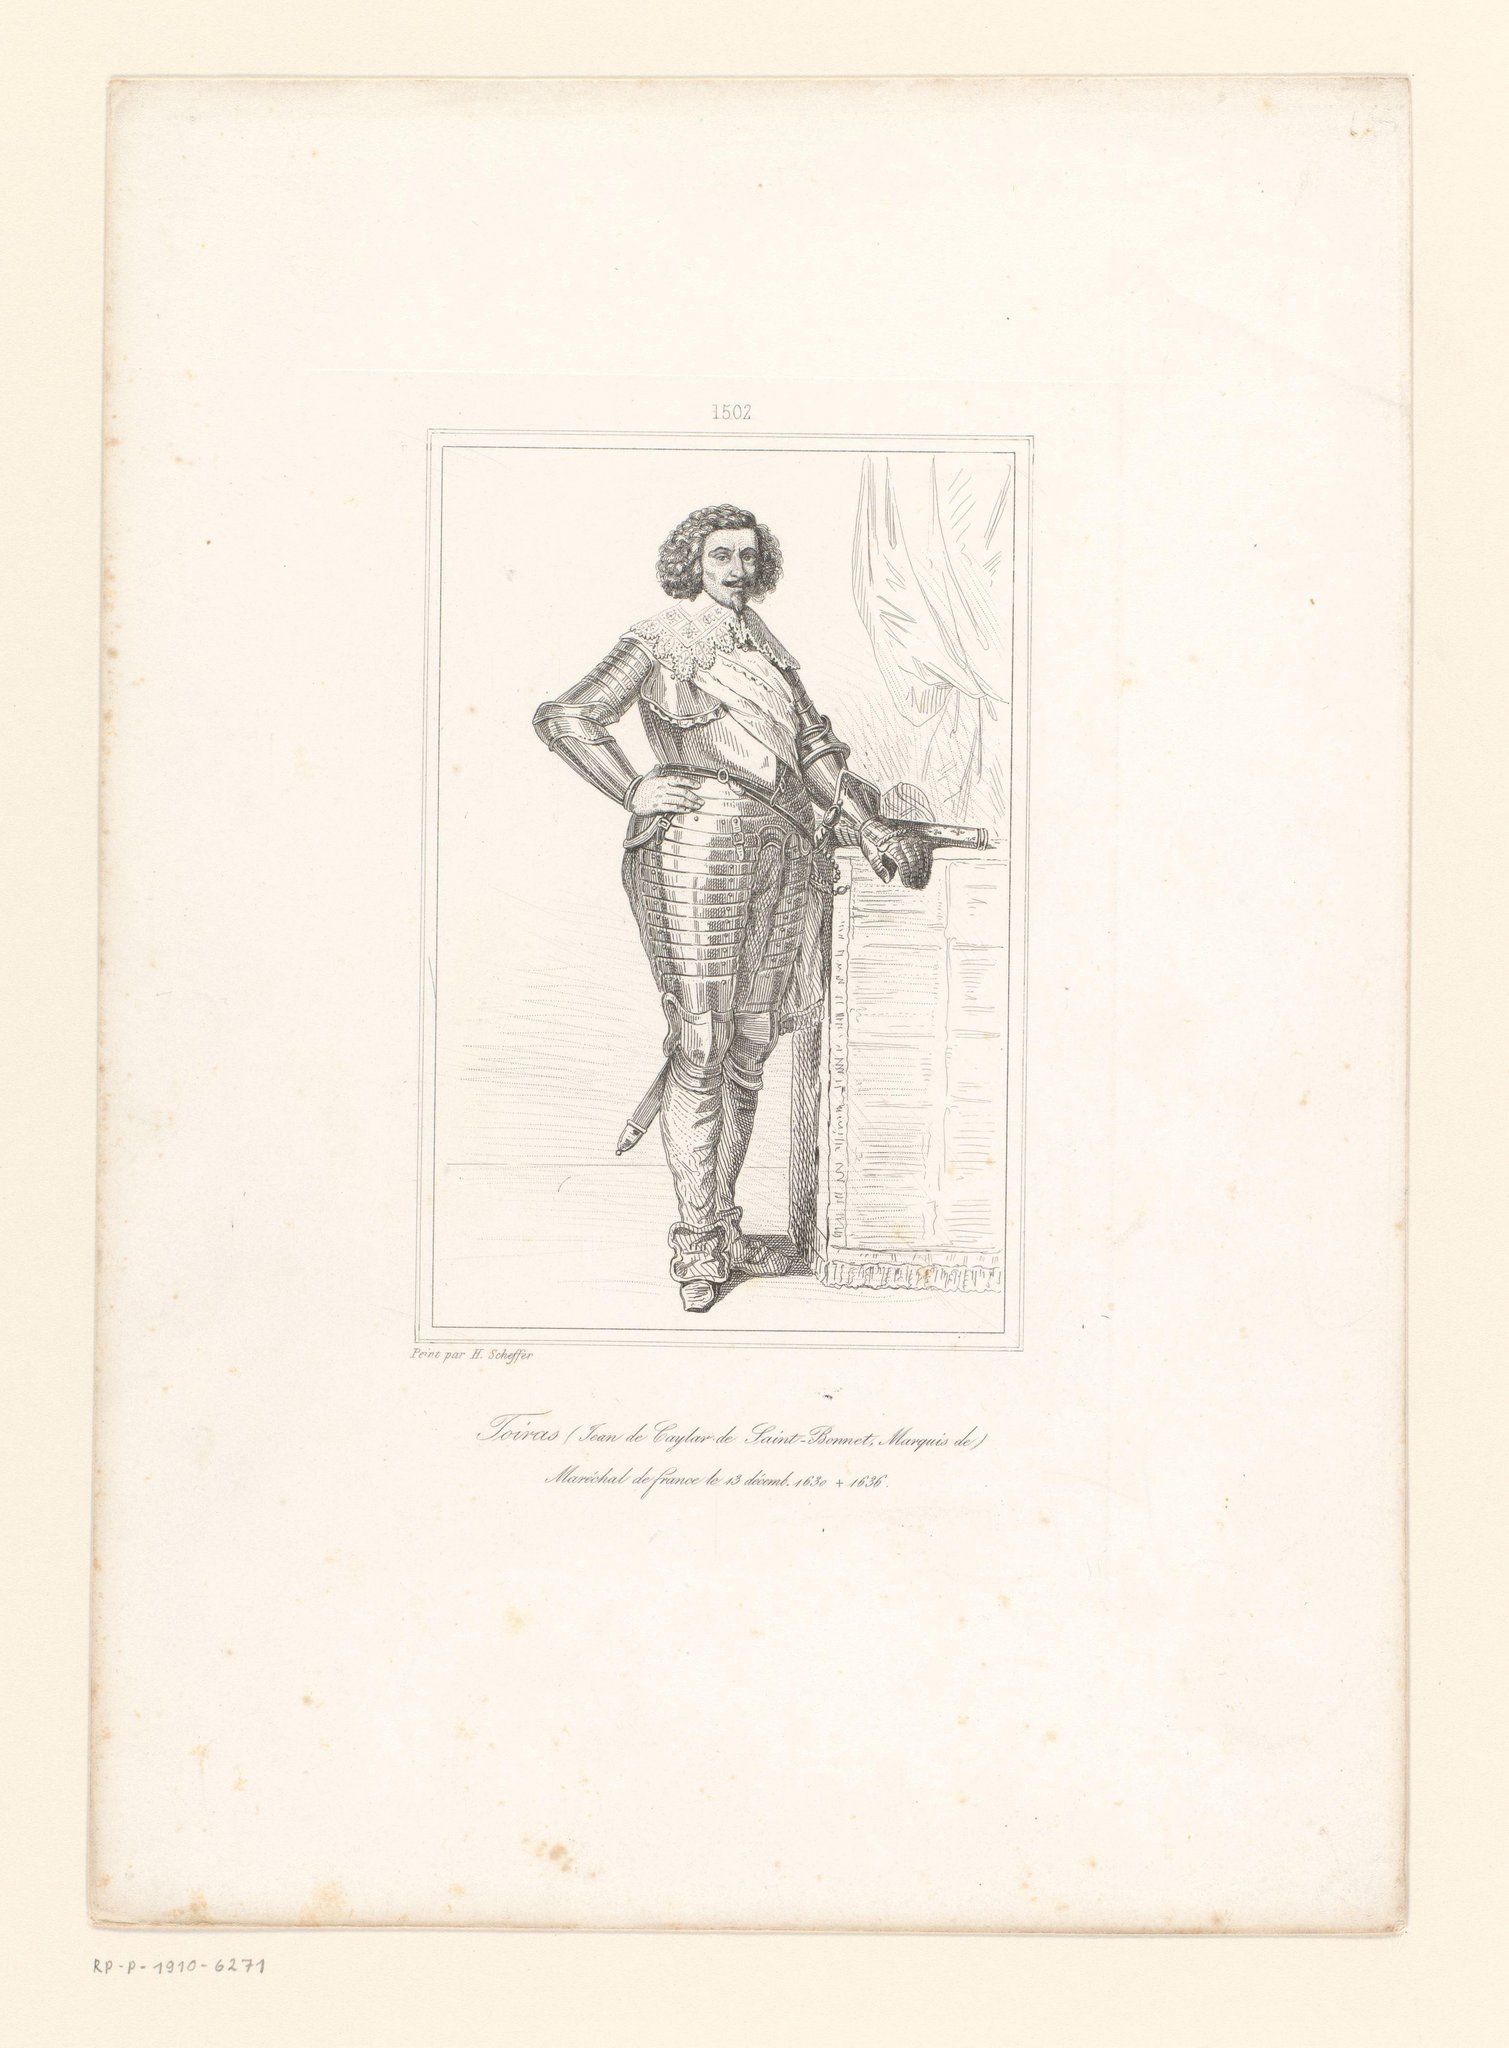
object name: print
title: Portret van Jean Caylar d'Anduze de Saint-Bonnet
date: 1830-1850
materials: paper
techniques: etching, roulette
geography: france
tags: commander-in-chief, general, marshal, historical persons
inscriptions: collector's mark: Lugt 2228